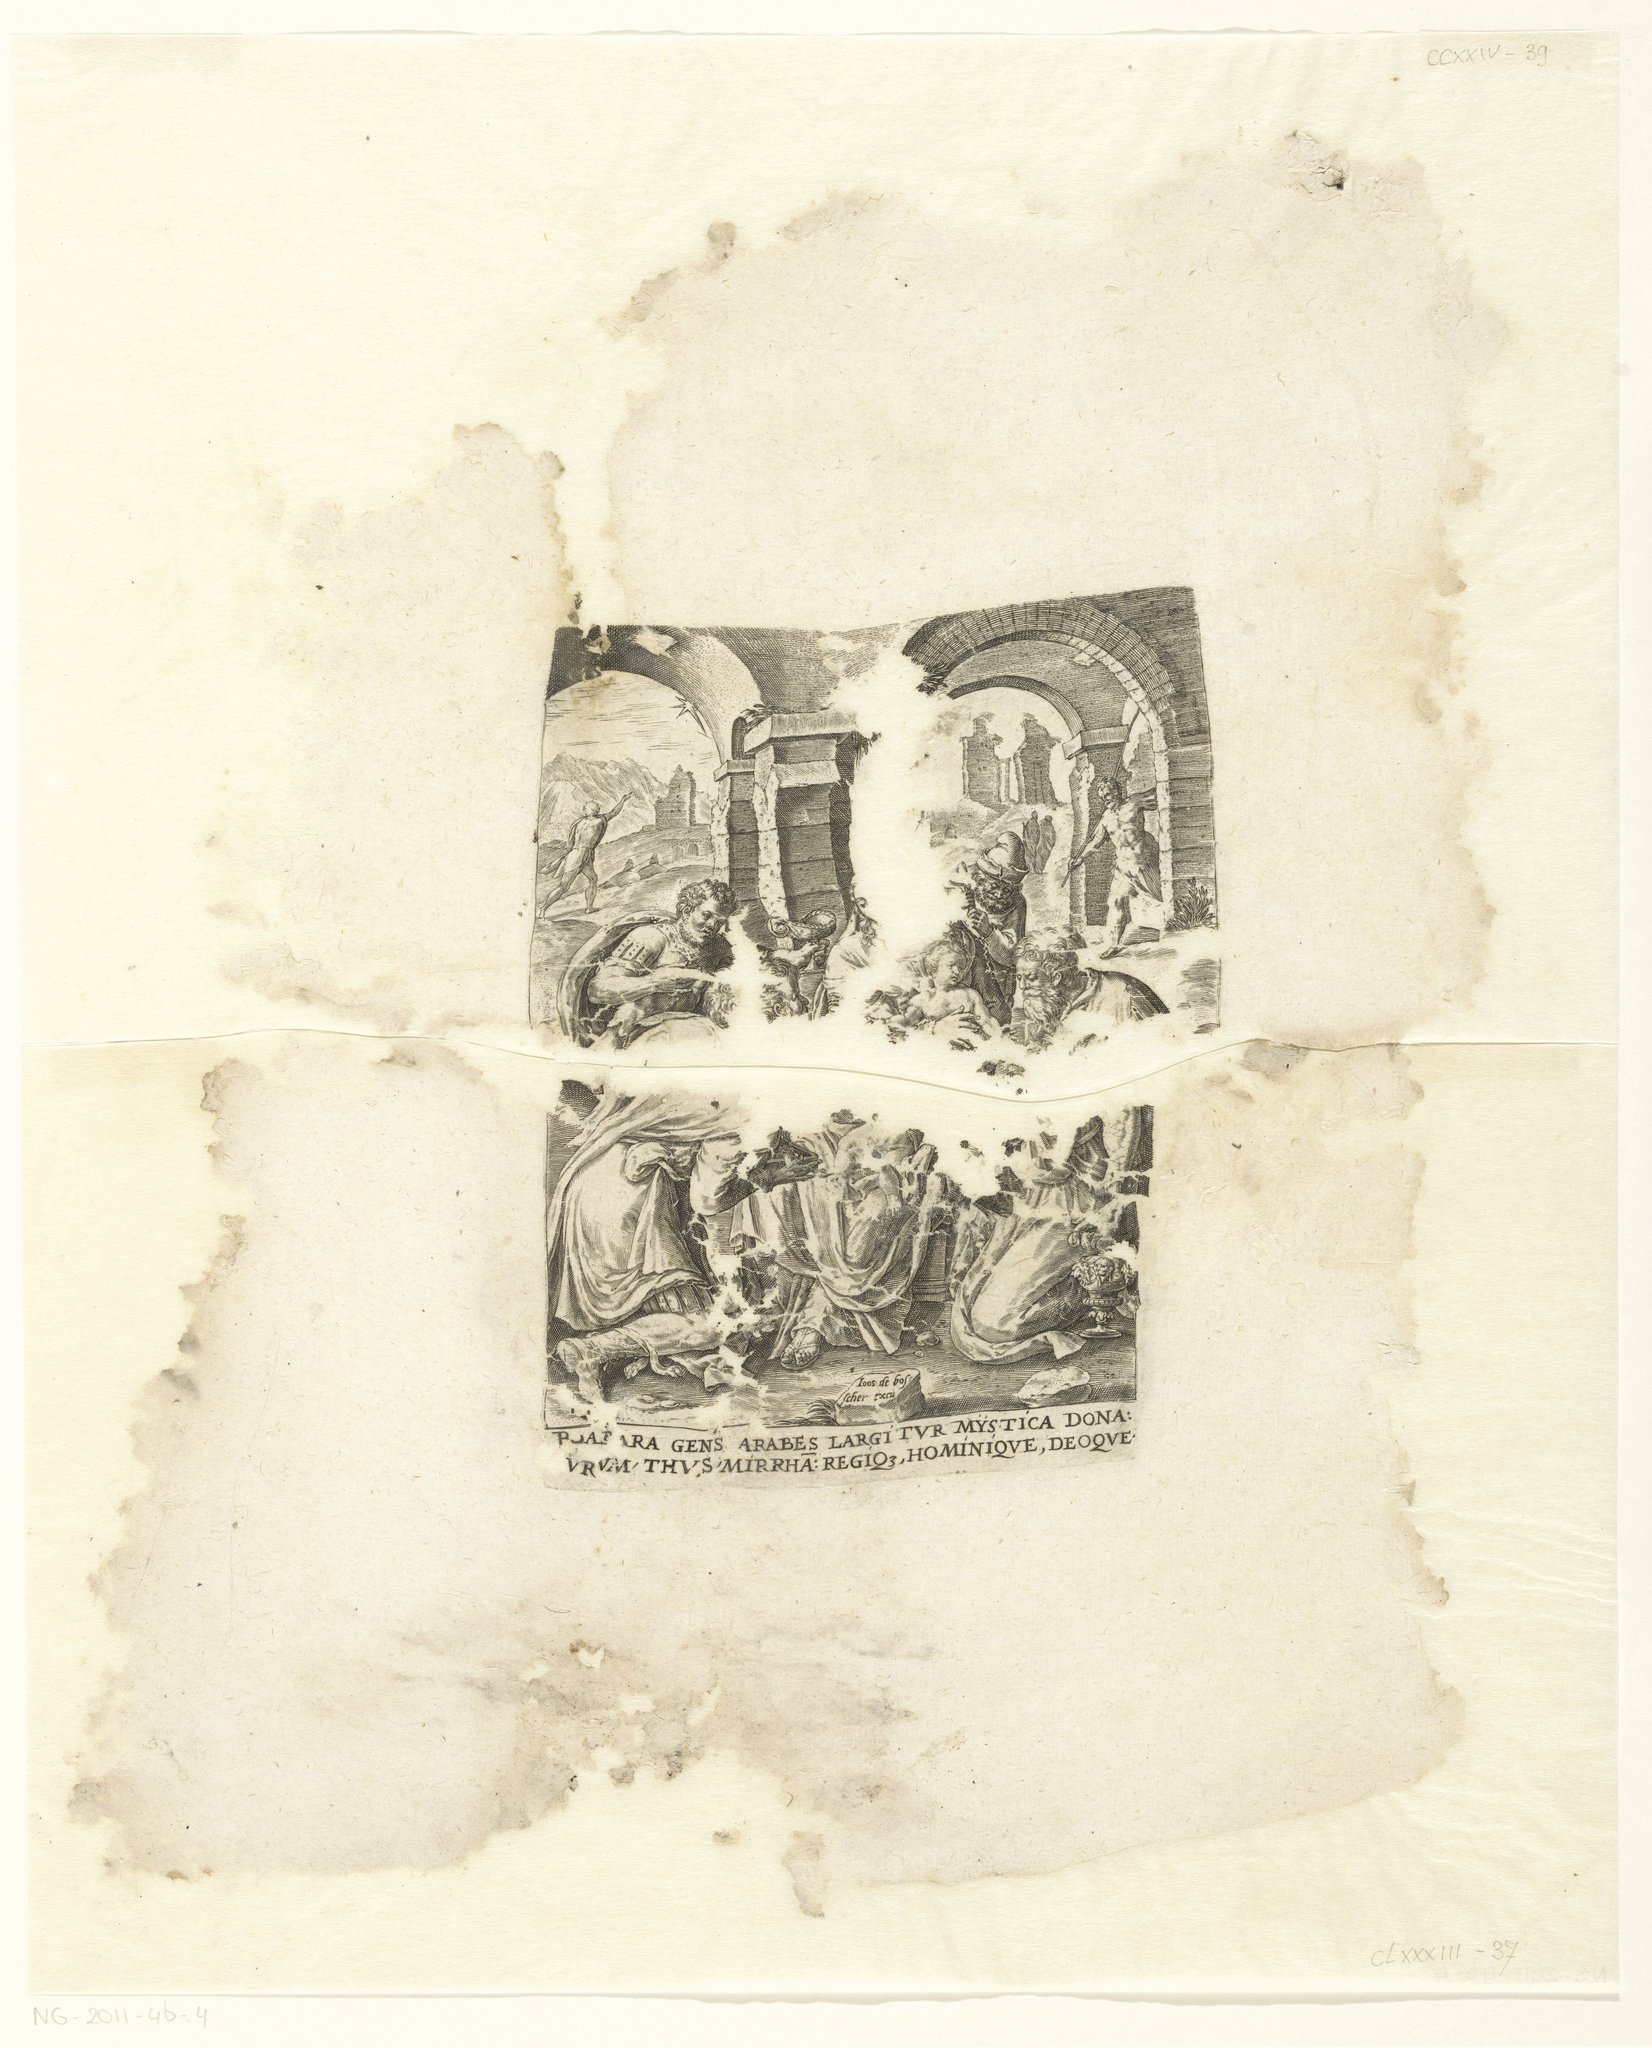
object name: print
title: Aanbidding door de koningen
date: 1570-1596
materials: paper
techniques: engraving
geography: southern netherlands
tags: adoration of the kings: the wise men present their gifts to the christ-child (gold, frankincense and myrrh)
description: Deze tot dusver onbekende door Joos de Bosscher uitgegeven prent kan nog tot diens Antwerpse uitgaven behoren. De prenten in de Nova Zembla collectie zijn tijdens een expeditie van Willem Barendsz en Jacob van Heemskerk in 1596-1597 noodgedwongen in het winterkamp, het ‘Behouden Huis’, op het eiland achtergelaten. De prenten waren in één of meerdere stapels als handelswaar meegenomen vanuit Amsterdam. Bijna drie eeuwen later, in 1871, keerde de Noor Elling Carlsen terug naar Nova Zembla en vond daar de restanten van het ‘Behouden Huis, inclusief een groot deel van de inventaris. Een deel van de prenten, in de vorm van aaneengekoekte kluiten, werd toen ook teruggevonden. De papierkluiten waren soms op meerdere plekken gebroken. Tussen 1975-1979 zijn de prenten van elkaar gescheiden. Dit leverde in totaal ca. 1000 fragmenten van ca. 400 afdrukken van ca. 150 verschillende prenten op. Voor zover mogelijk zijn de fragmenten samengevoegd en zijn de prenten gereconstrueerd.